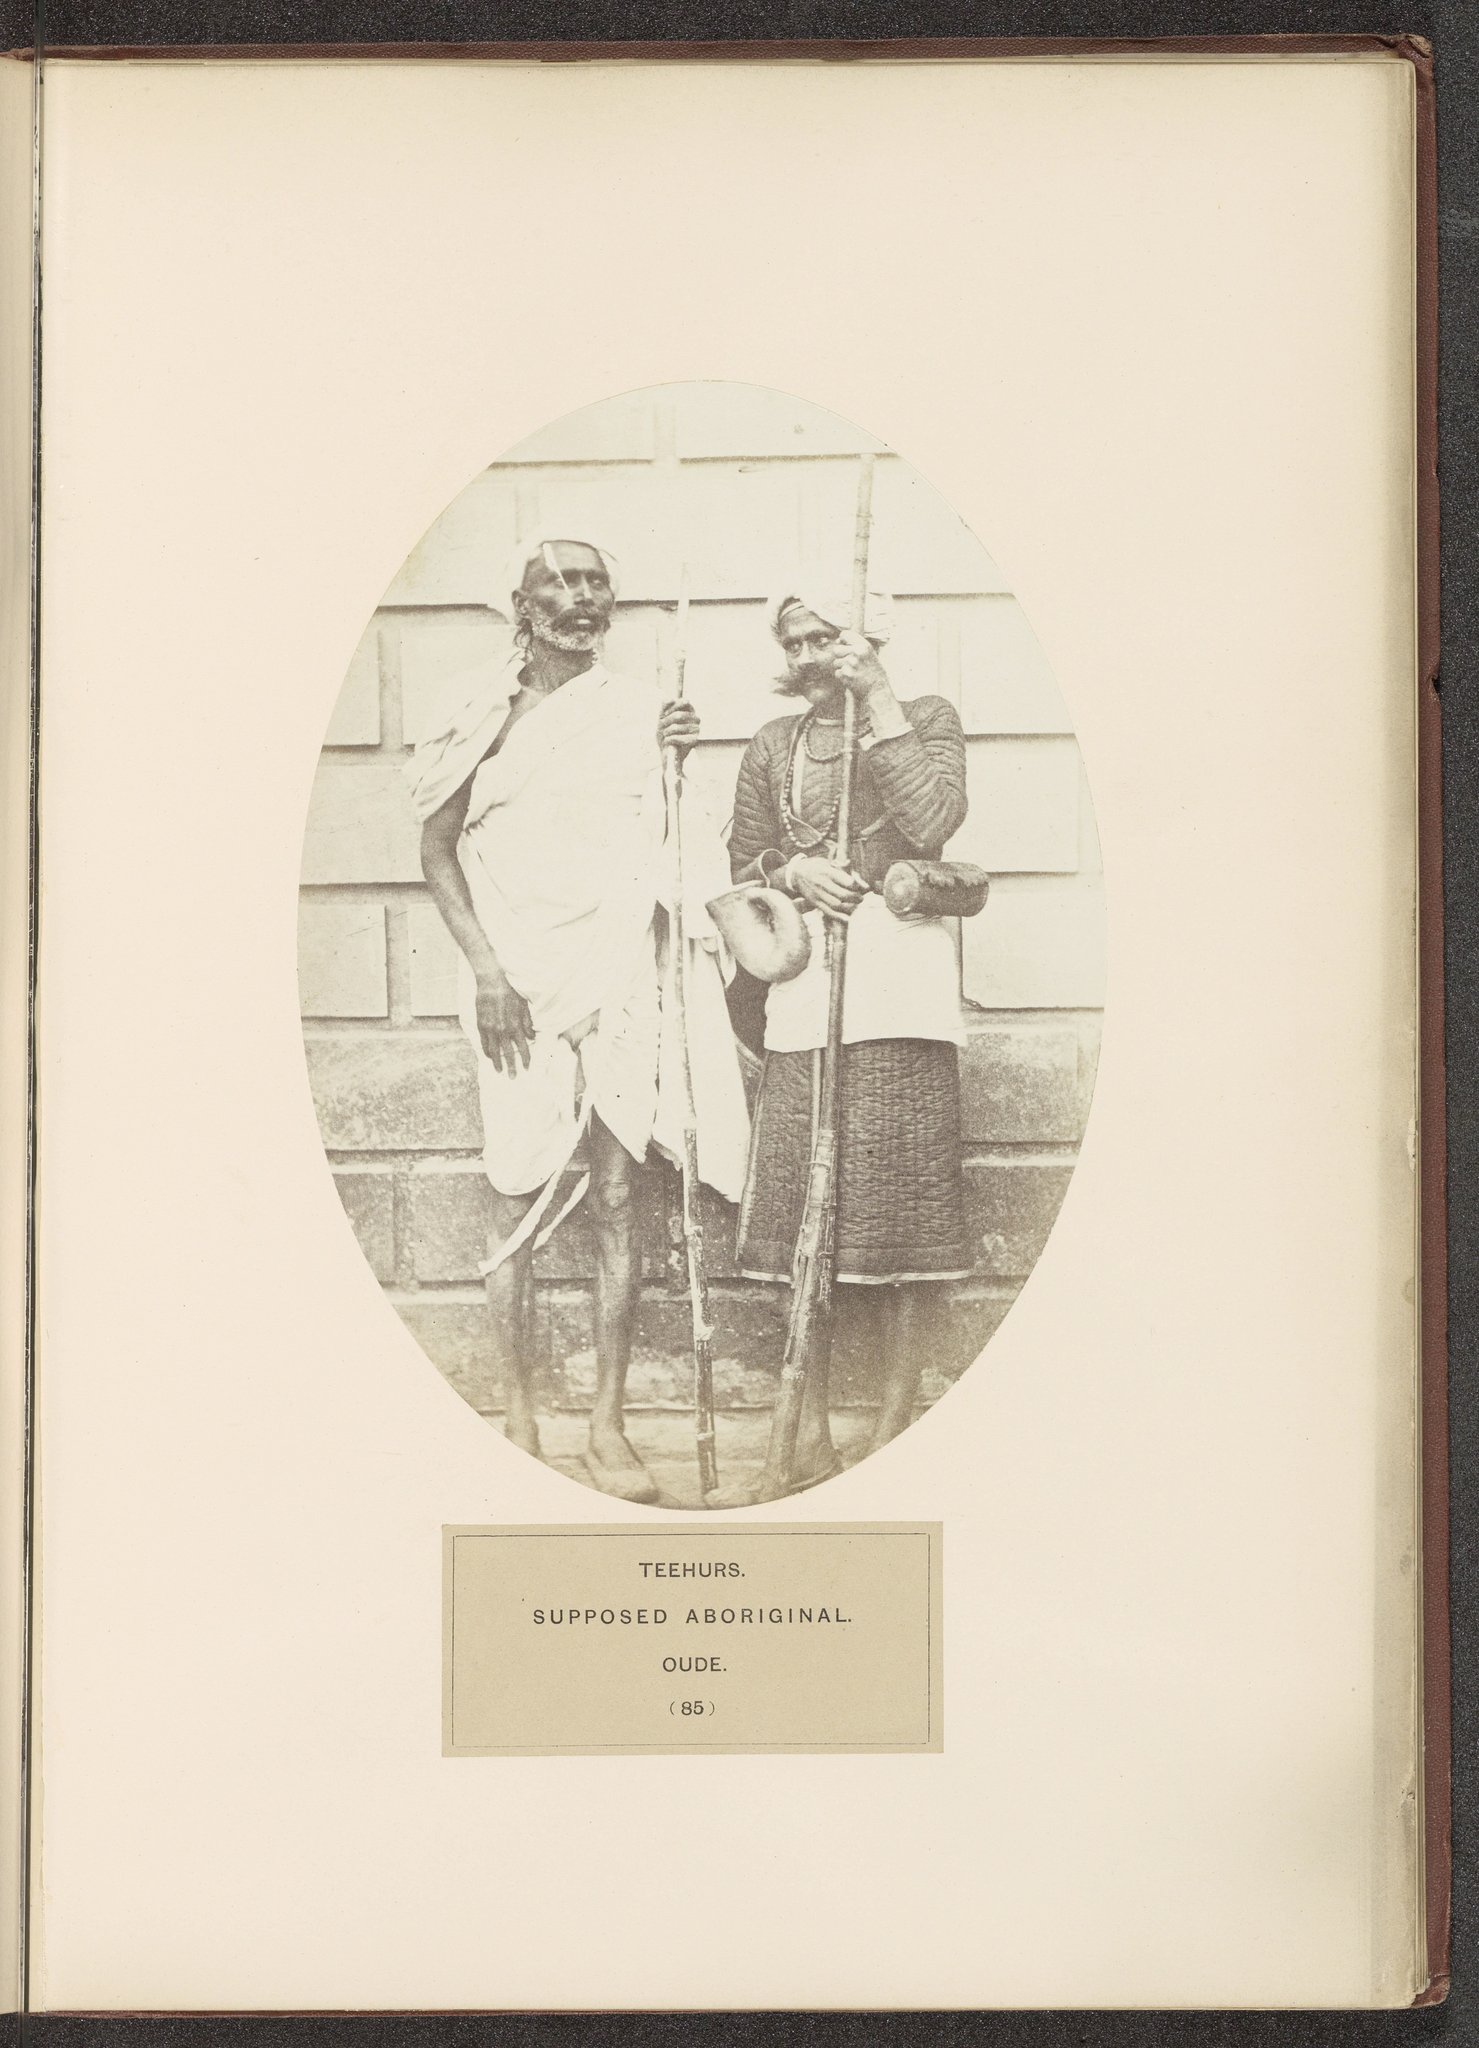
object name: page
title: Portrait of two unknown men from Awadh, Uttar Pradesh, India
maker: Anonymous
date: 1858-1868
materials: photographic support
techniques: albumen print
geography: uttar pradesh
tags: human races; peoples; nationalities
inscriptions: inscription: ‘TEEHURS./ SUPPOSED ABORIGINAL./ OUDE.’, number: ‘(85)’